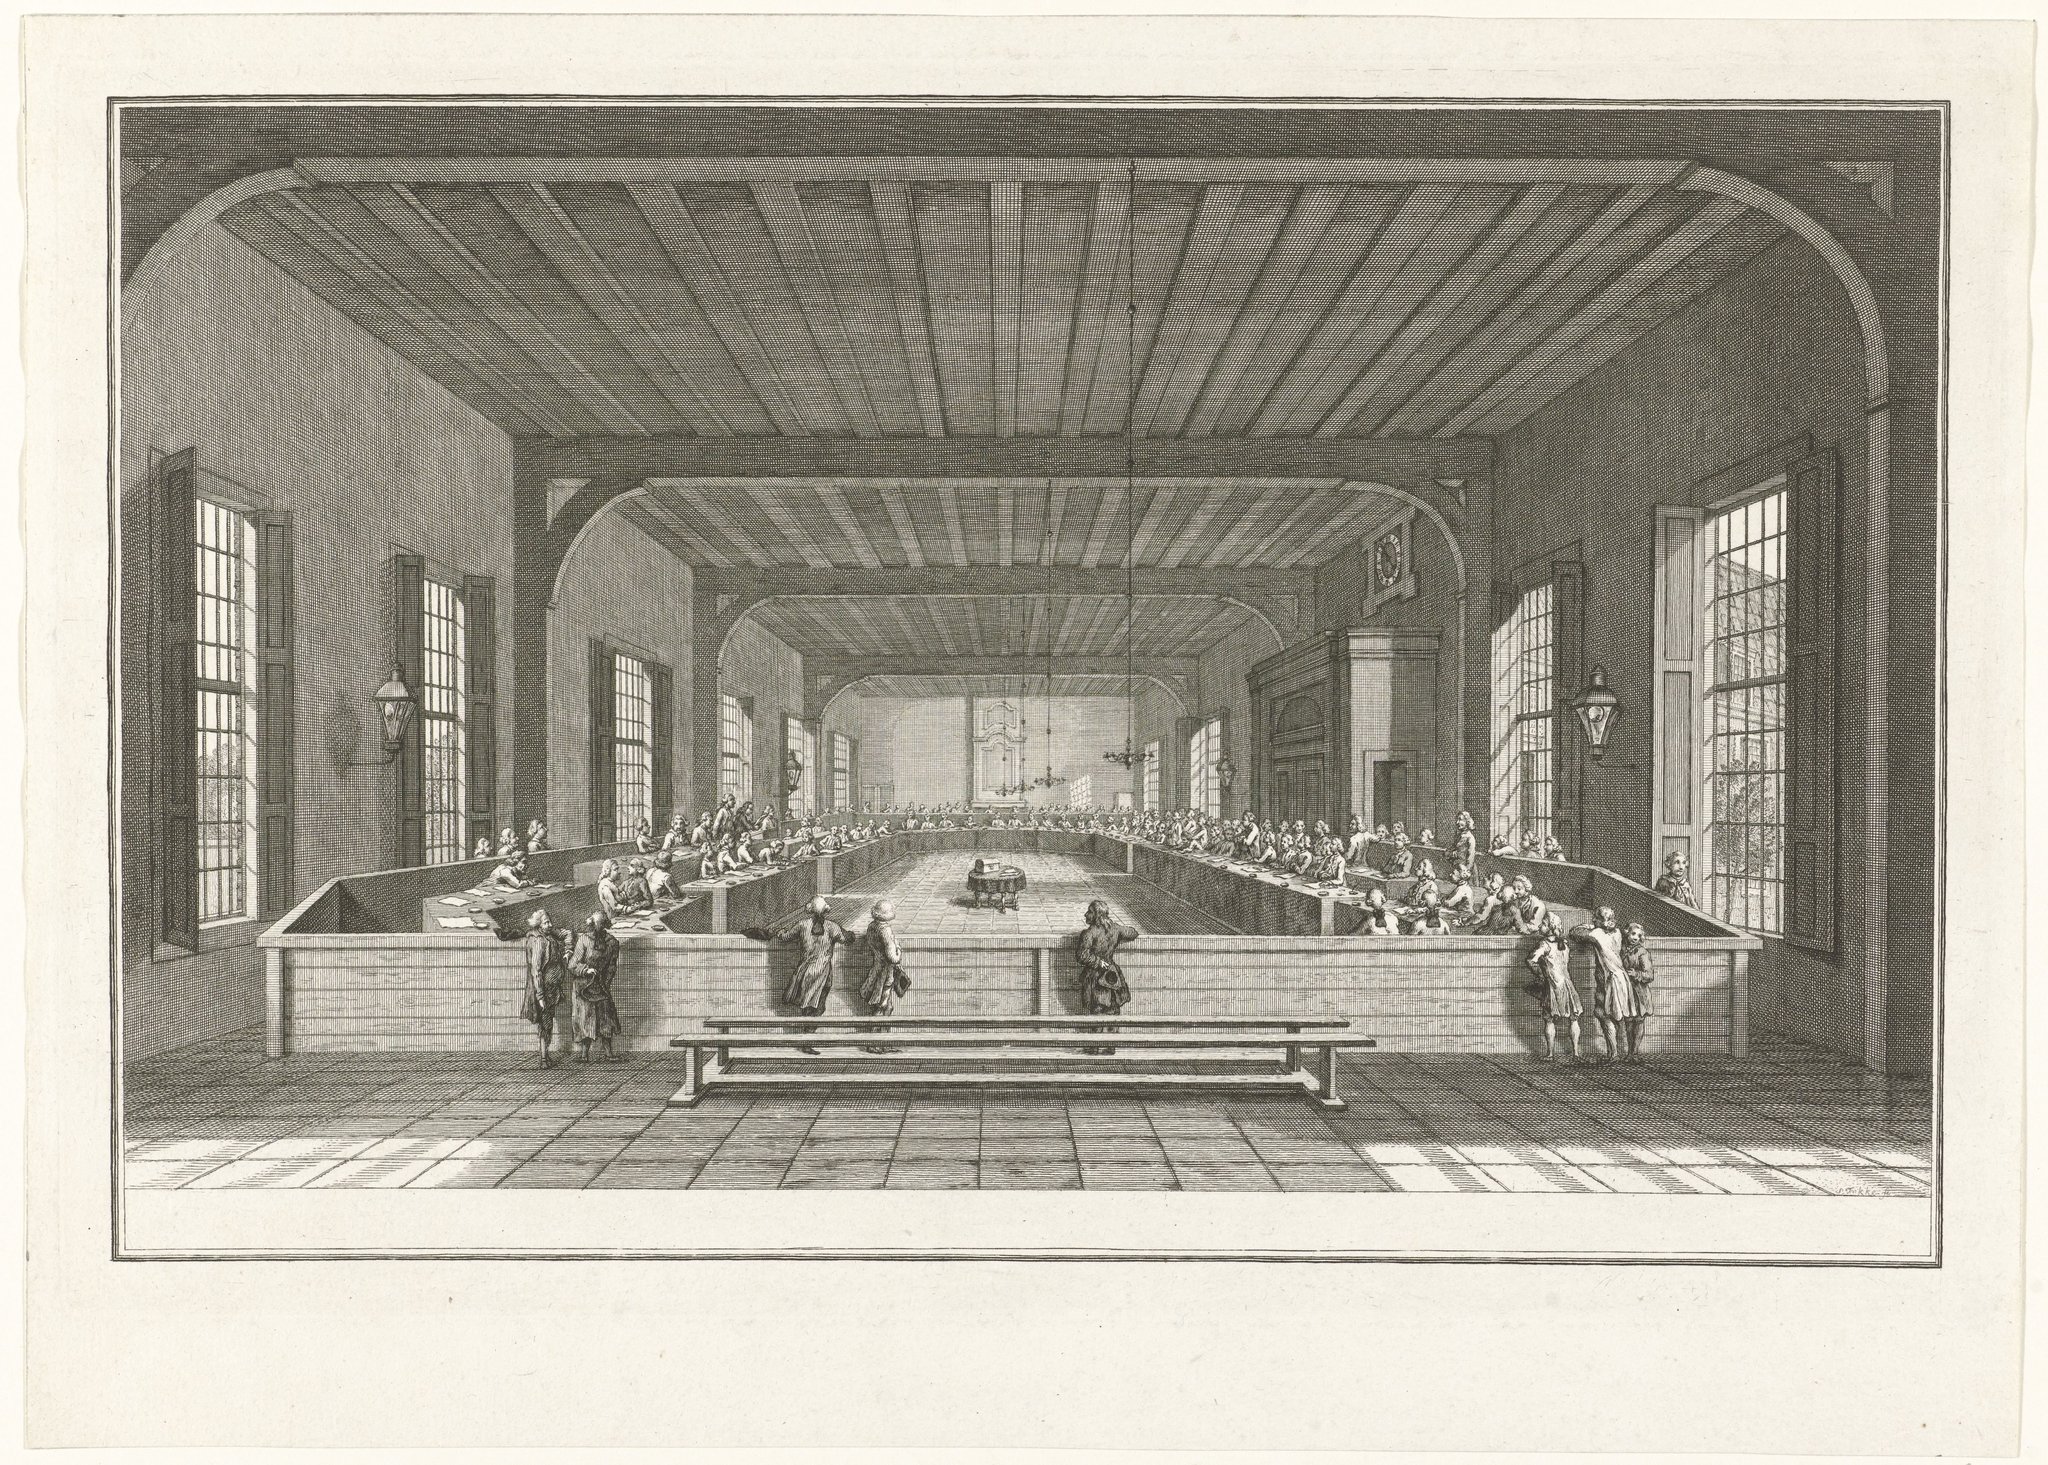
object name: print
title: Eerste vergadering van de Oeconomische tak van de Maatschappij der Wetenschappen te Haarlem, 1778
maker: simon fokke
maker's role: draughtsman, print maker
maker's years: 1712-1784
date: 1778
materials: paper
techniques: engraving, etching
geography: northern netherlands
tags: meeting, assembly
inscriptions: collector's mark: Lugt 2228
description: Gezicht op de eerste vergadering van de nieuwe Oeconomische tak van de Maatschappij der Wetenschappen te Haarlem, gehouden op 15 september 1778 in de zaal van het Diaconiehuis te Haarlem